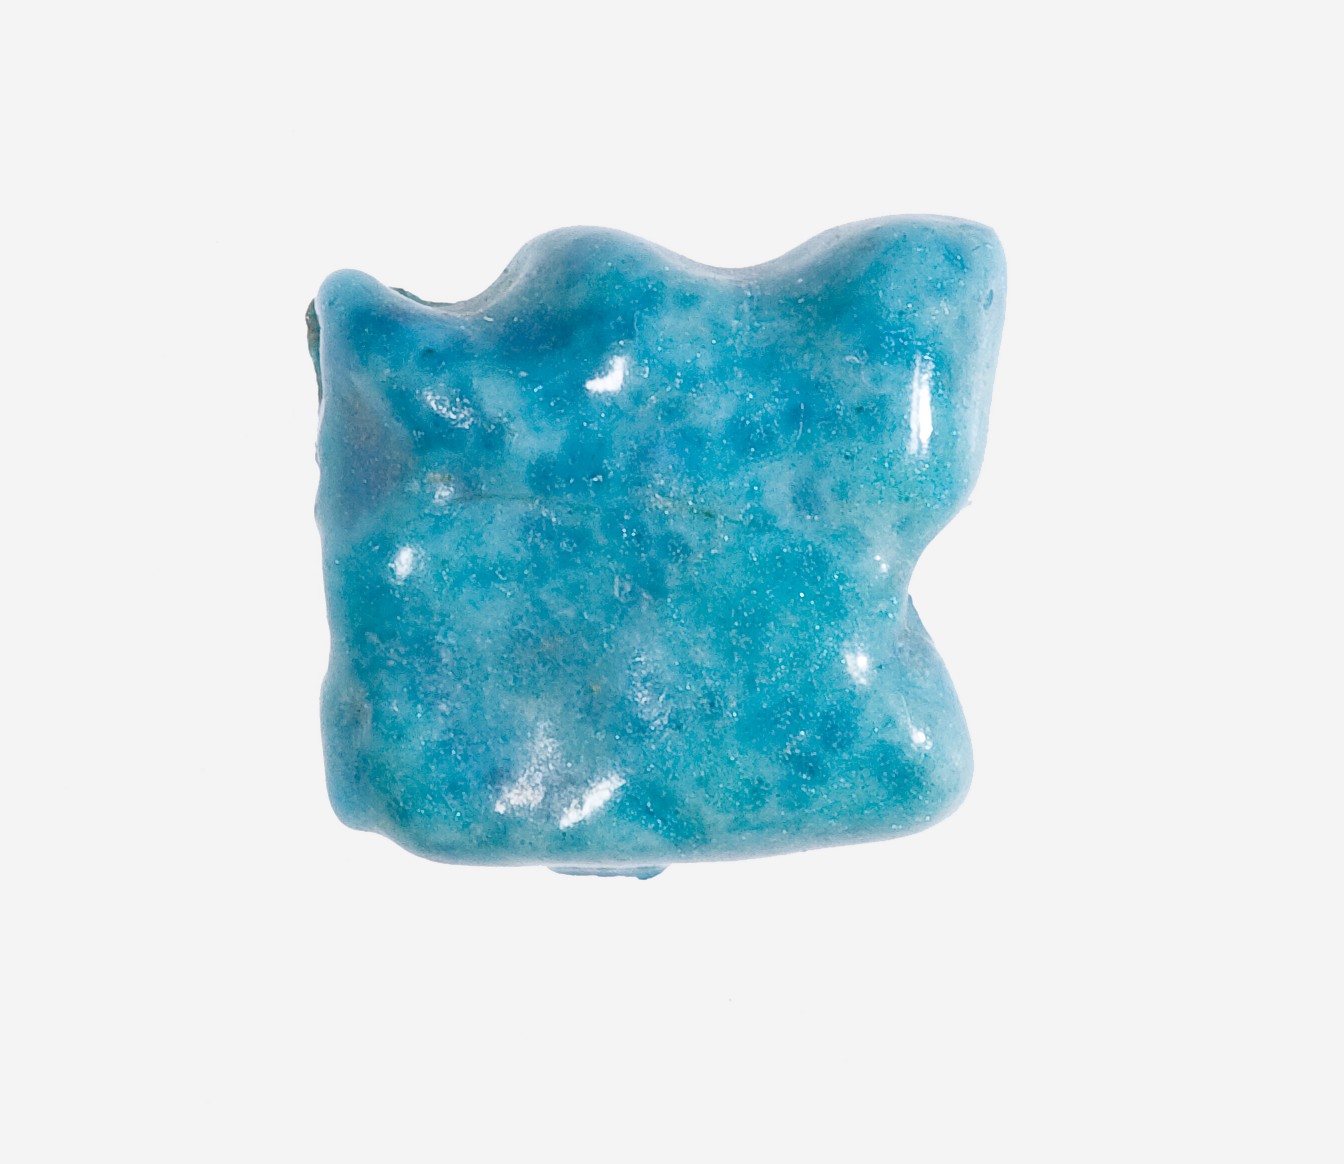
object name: pendant, lily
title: Pendant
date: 1390-1352 BCE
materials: faience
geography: egypt